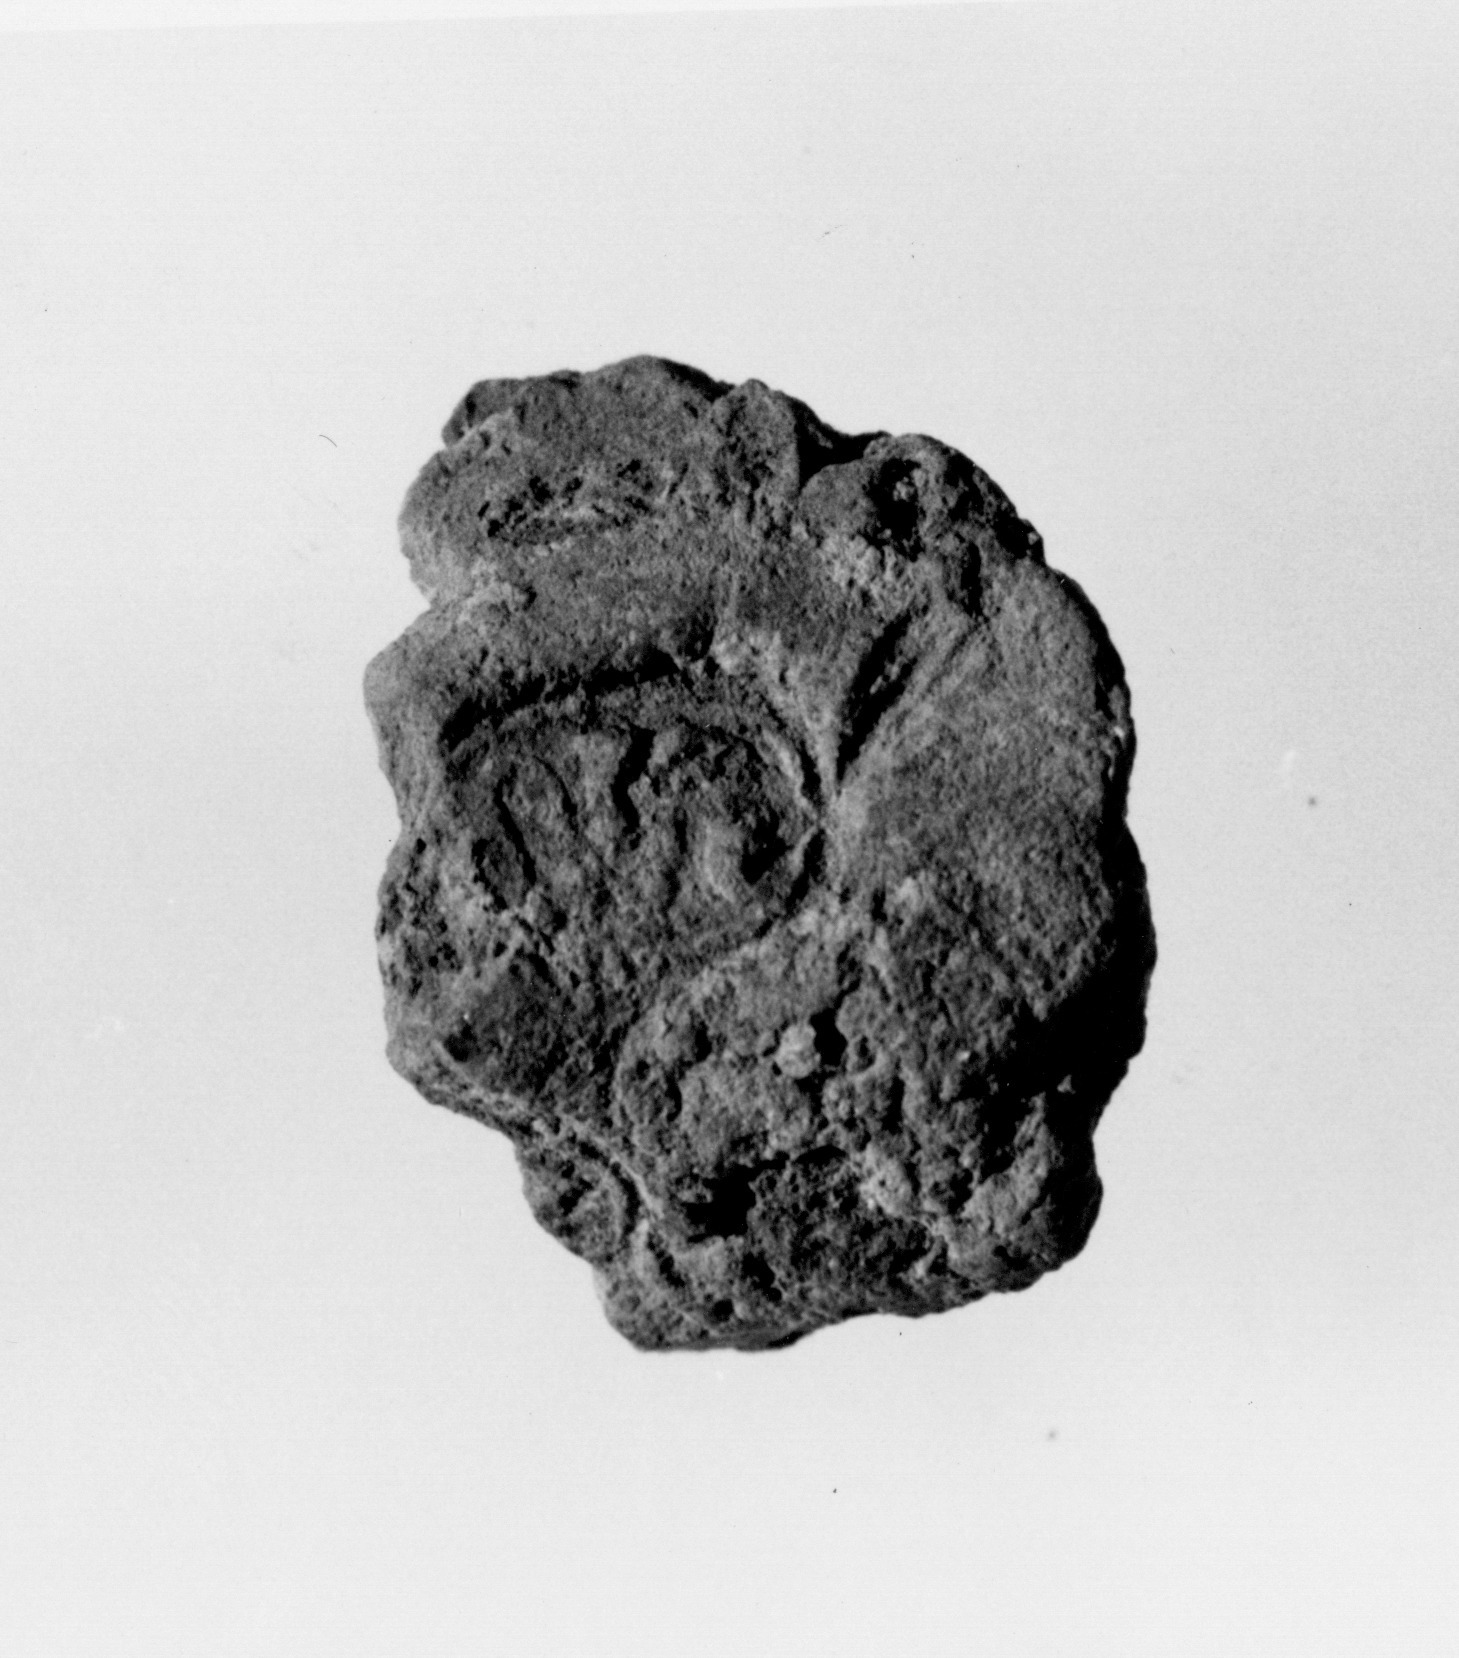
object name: sealing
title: Document Sealing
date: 1390-1352 BCE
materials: mud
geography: egypt